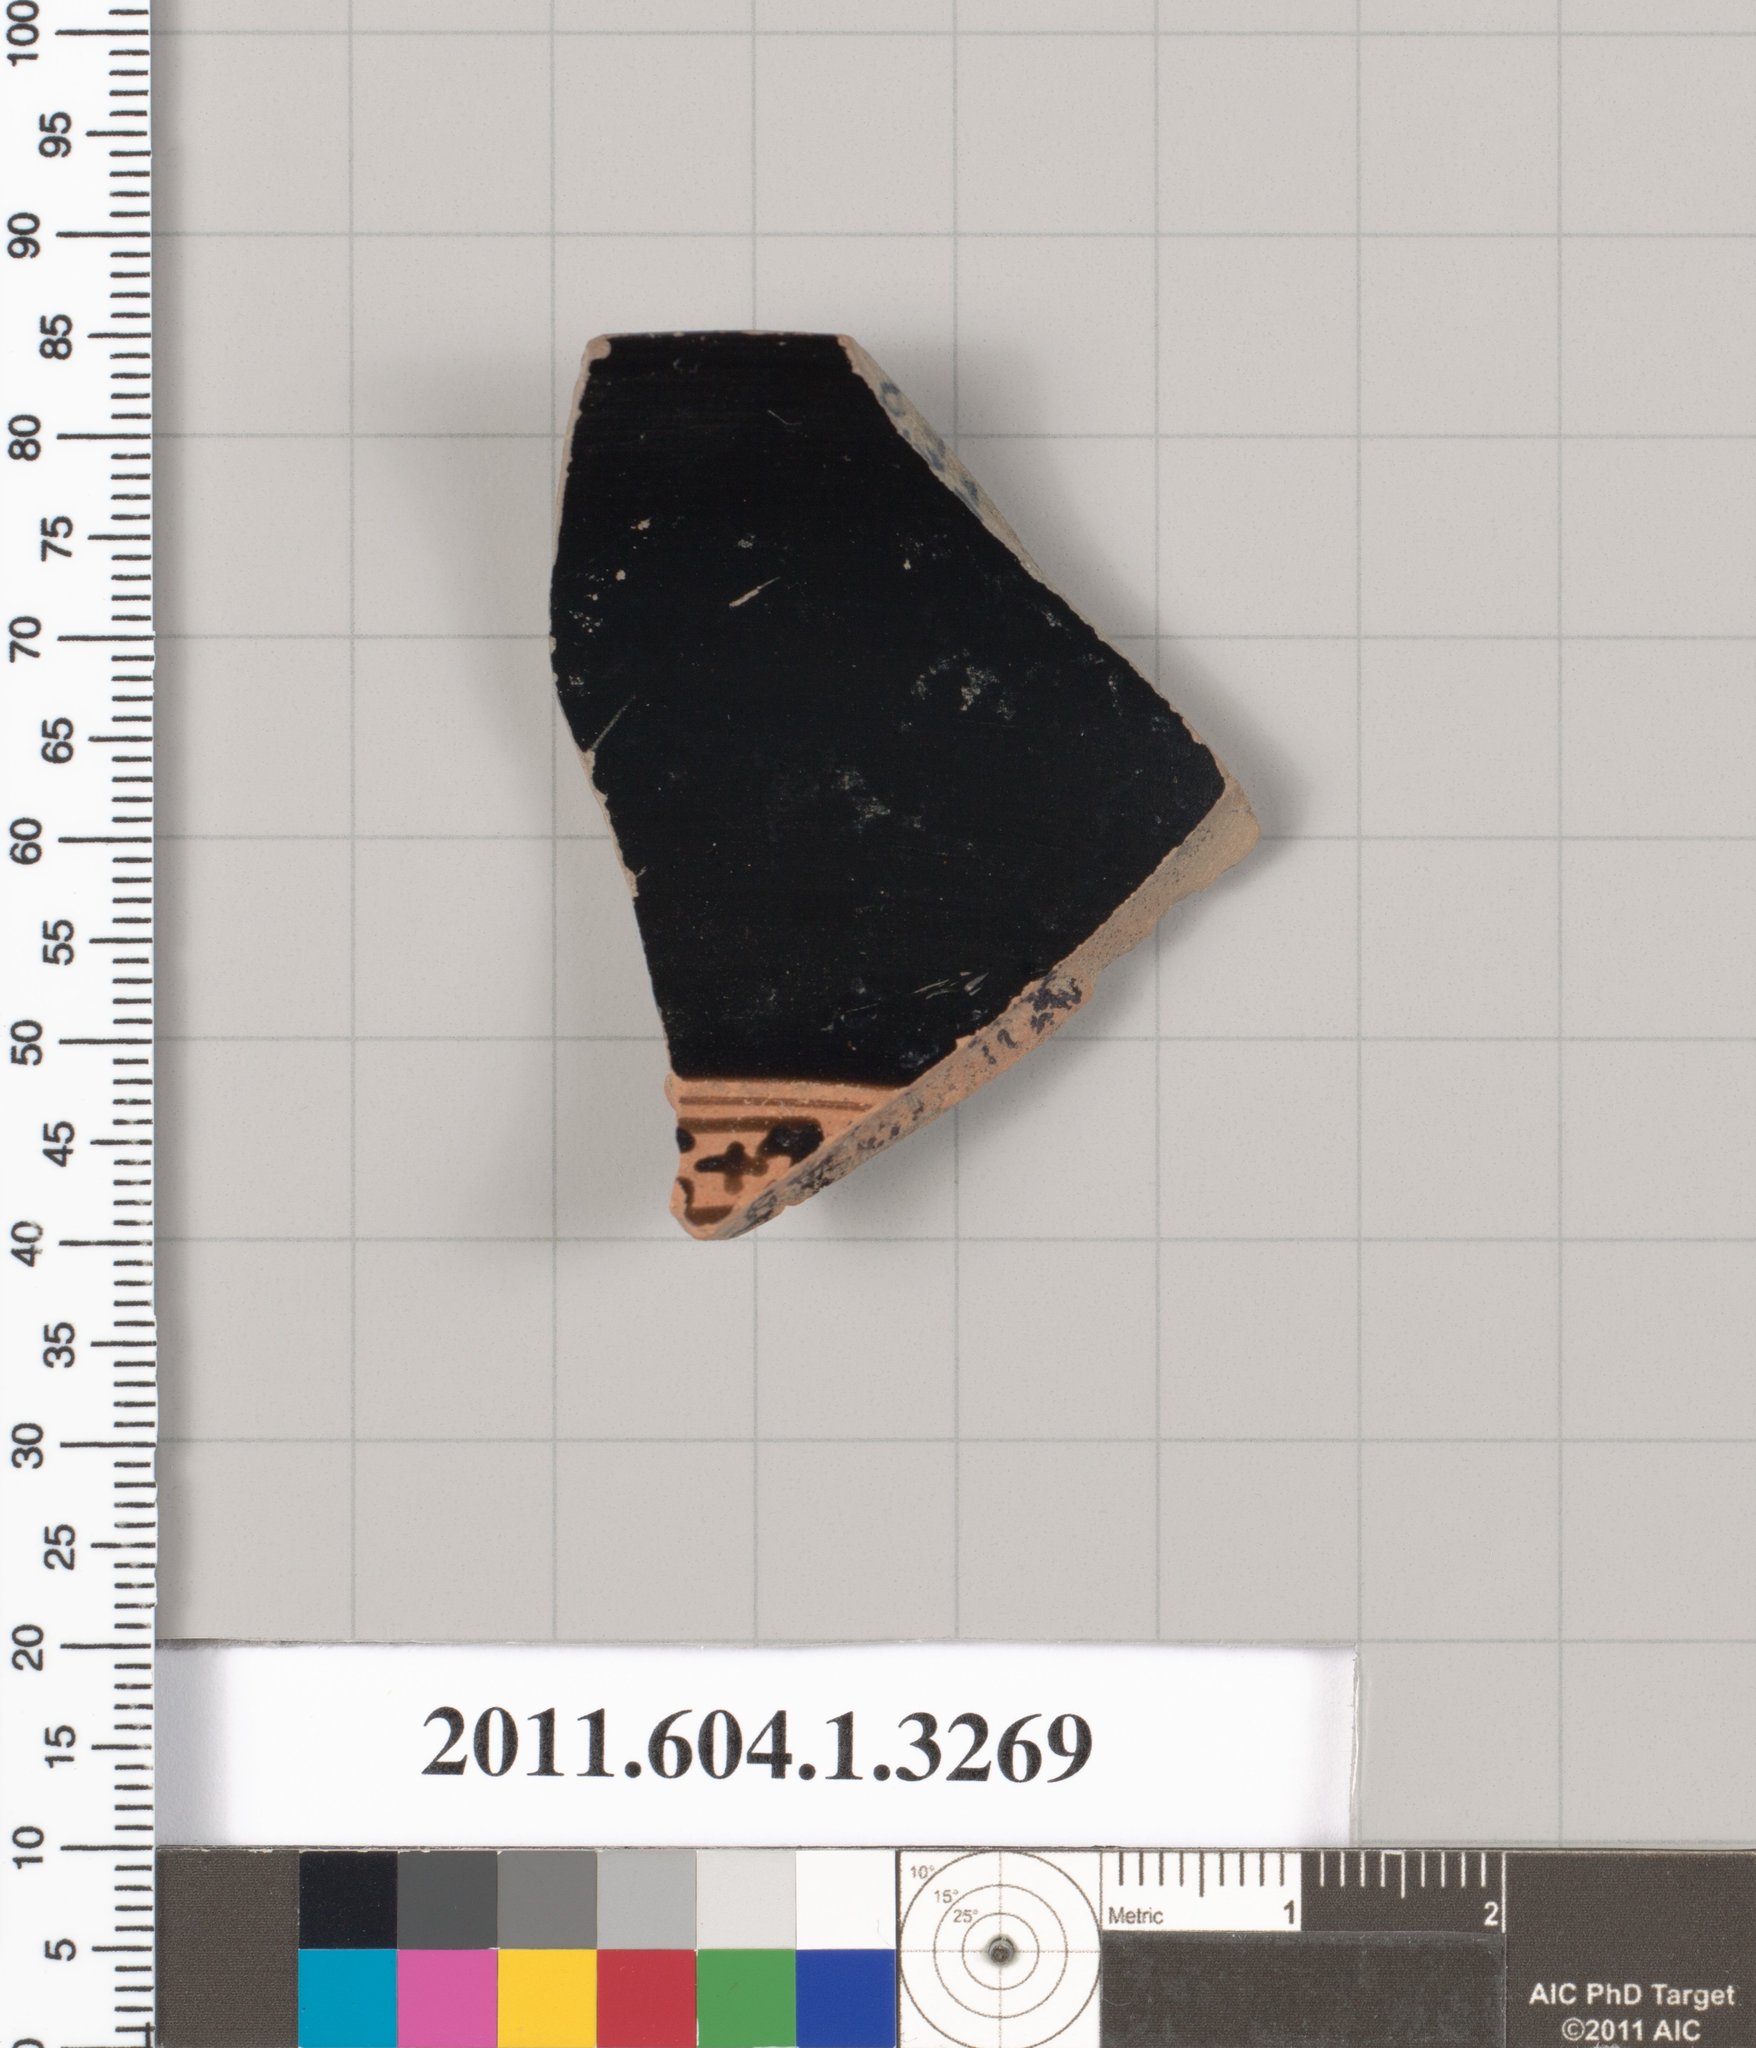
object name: kylix fragment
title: Terracotta fragment of a kylix (drinking cup)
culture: greek, attic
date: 500-490 BCE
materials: terracotta